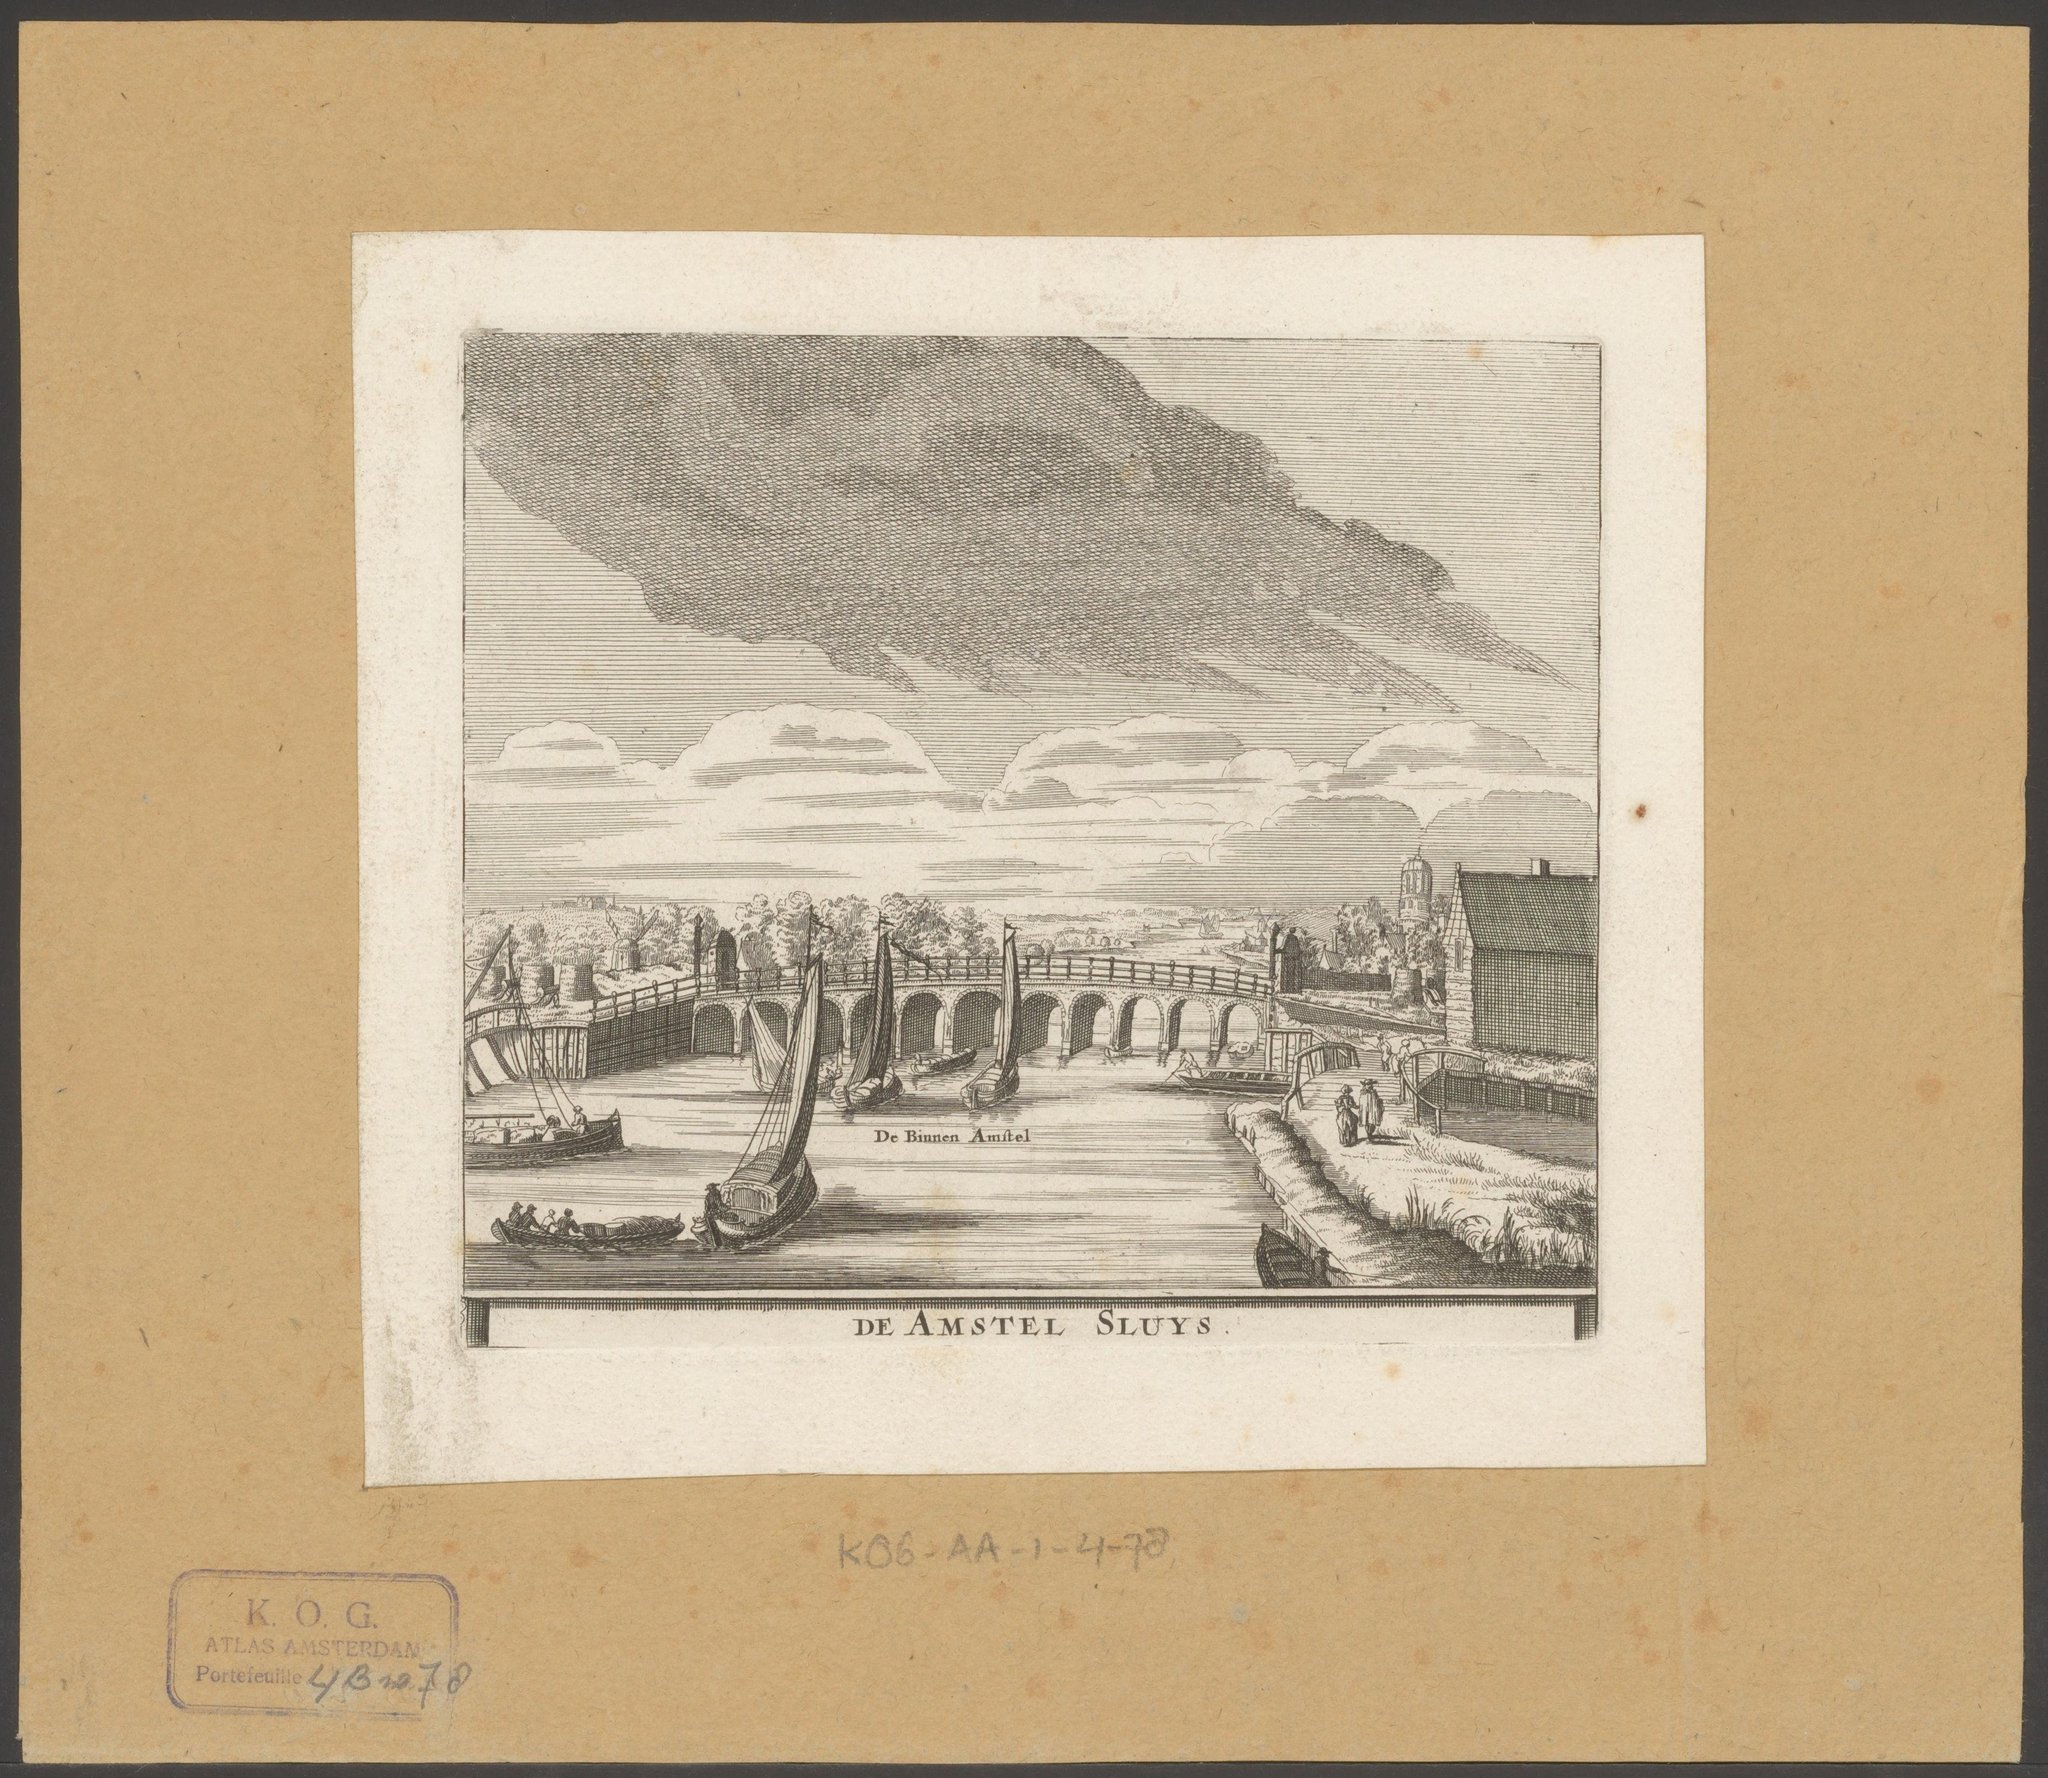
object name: print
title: Gezicht op de Binnen-Amstel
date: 1668-1699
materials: paper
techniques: etching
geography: amsterdam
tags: sluice, weir, sailing-ship, sailing-boat, city-view in general; 'veduta', canal, bridge in city across river, canal, etc.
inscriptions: collector's mark: ‘4B no 78’ Lugt 1641b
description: Onderwerpsrubriek binnen de Atlas Amsterdam: Amstel van Blauwbrug tot Hogesluis.